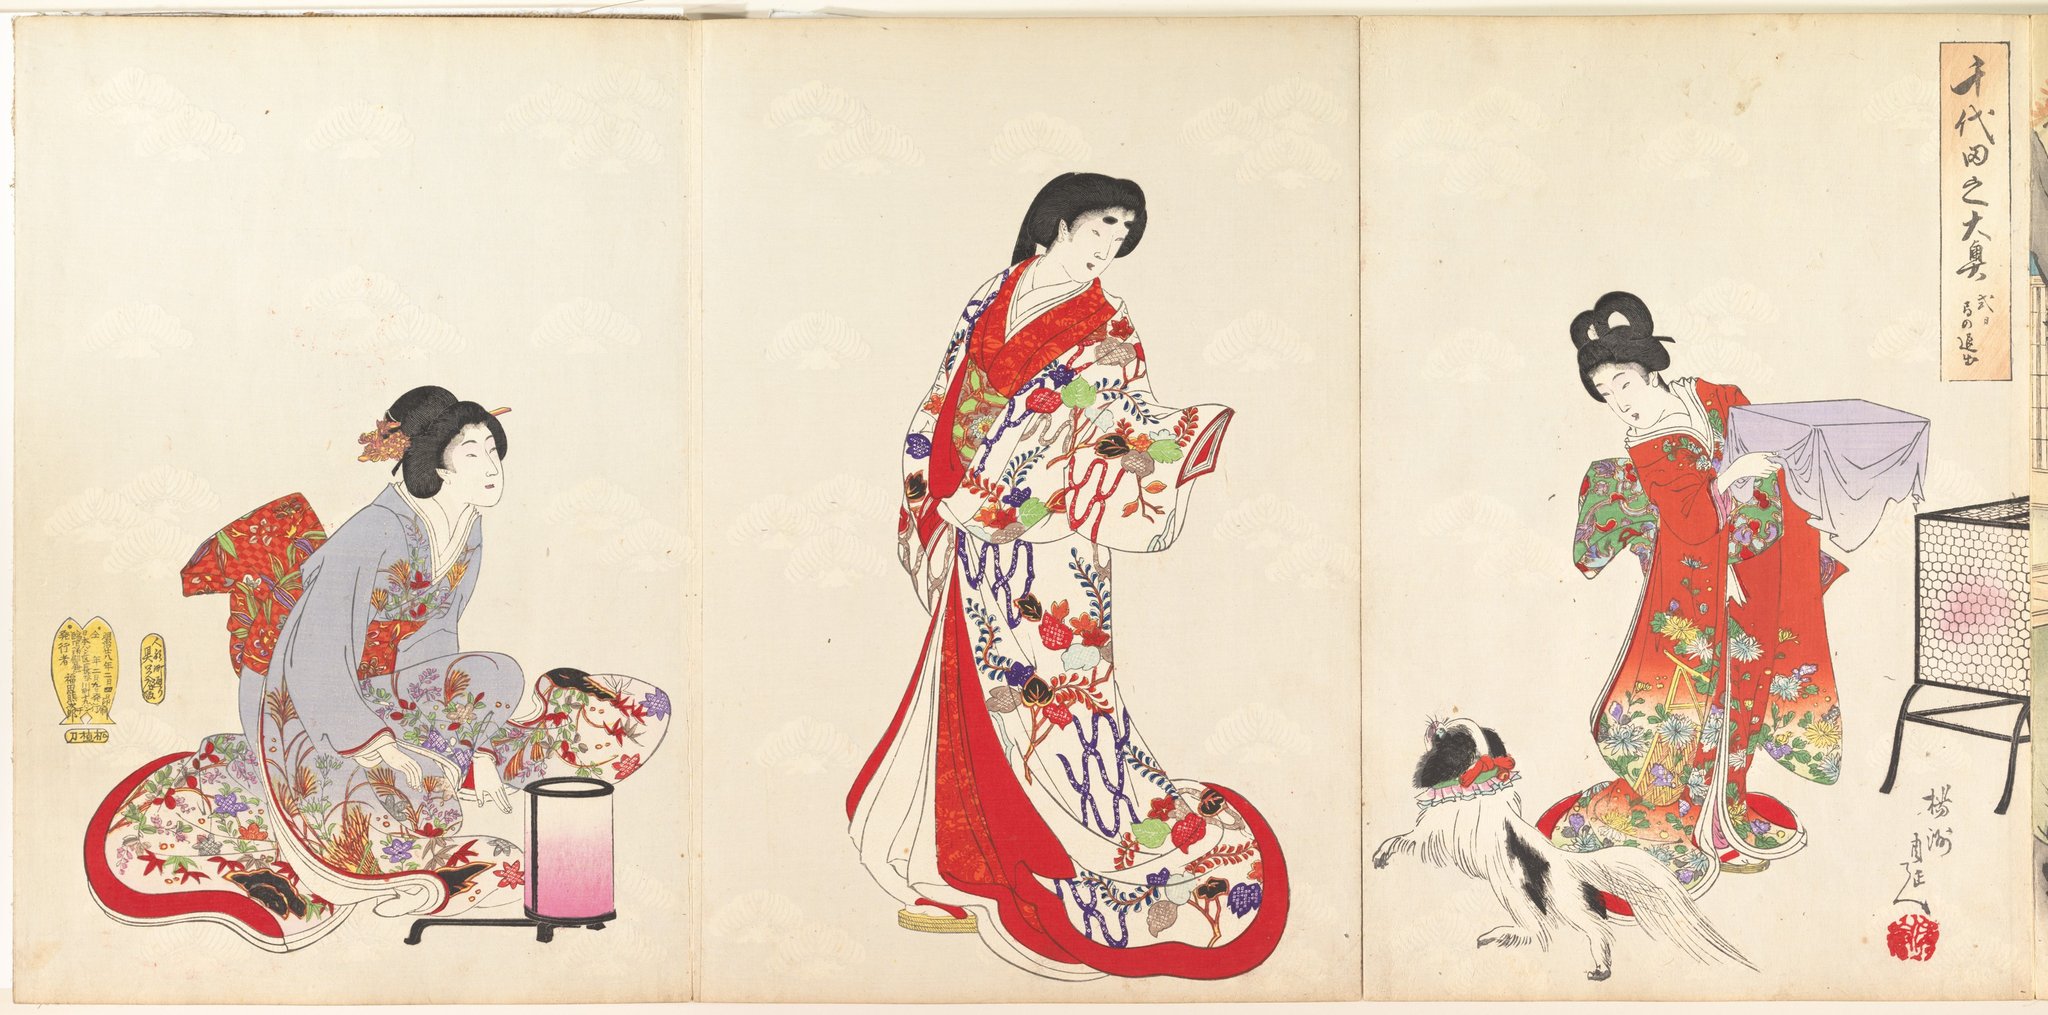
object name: print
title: Chiyoda Castle (Album of Women)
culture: japanese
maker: yōshū (hashimoto) chikanobu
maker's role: artist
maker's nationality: japanese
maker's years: 1838-1912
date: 1895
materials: ink, paper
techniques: woodblock print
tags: women,dogs